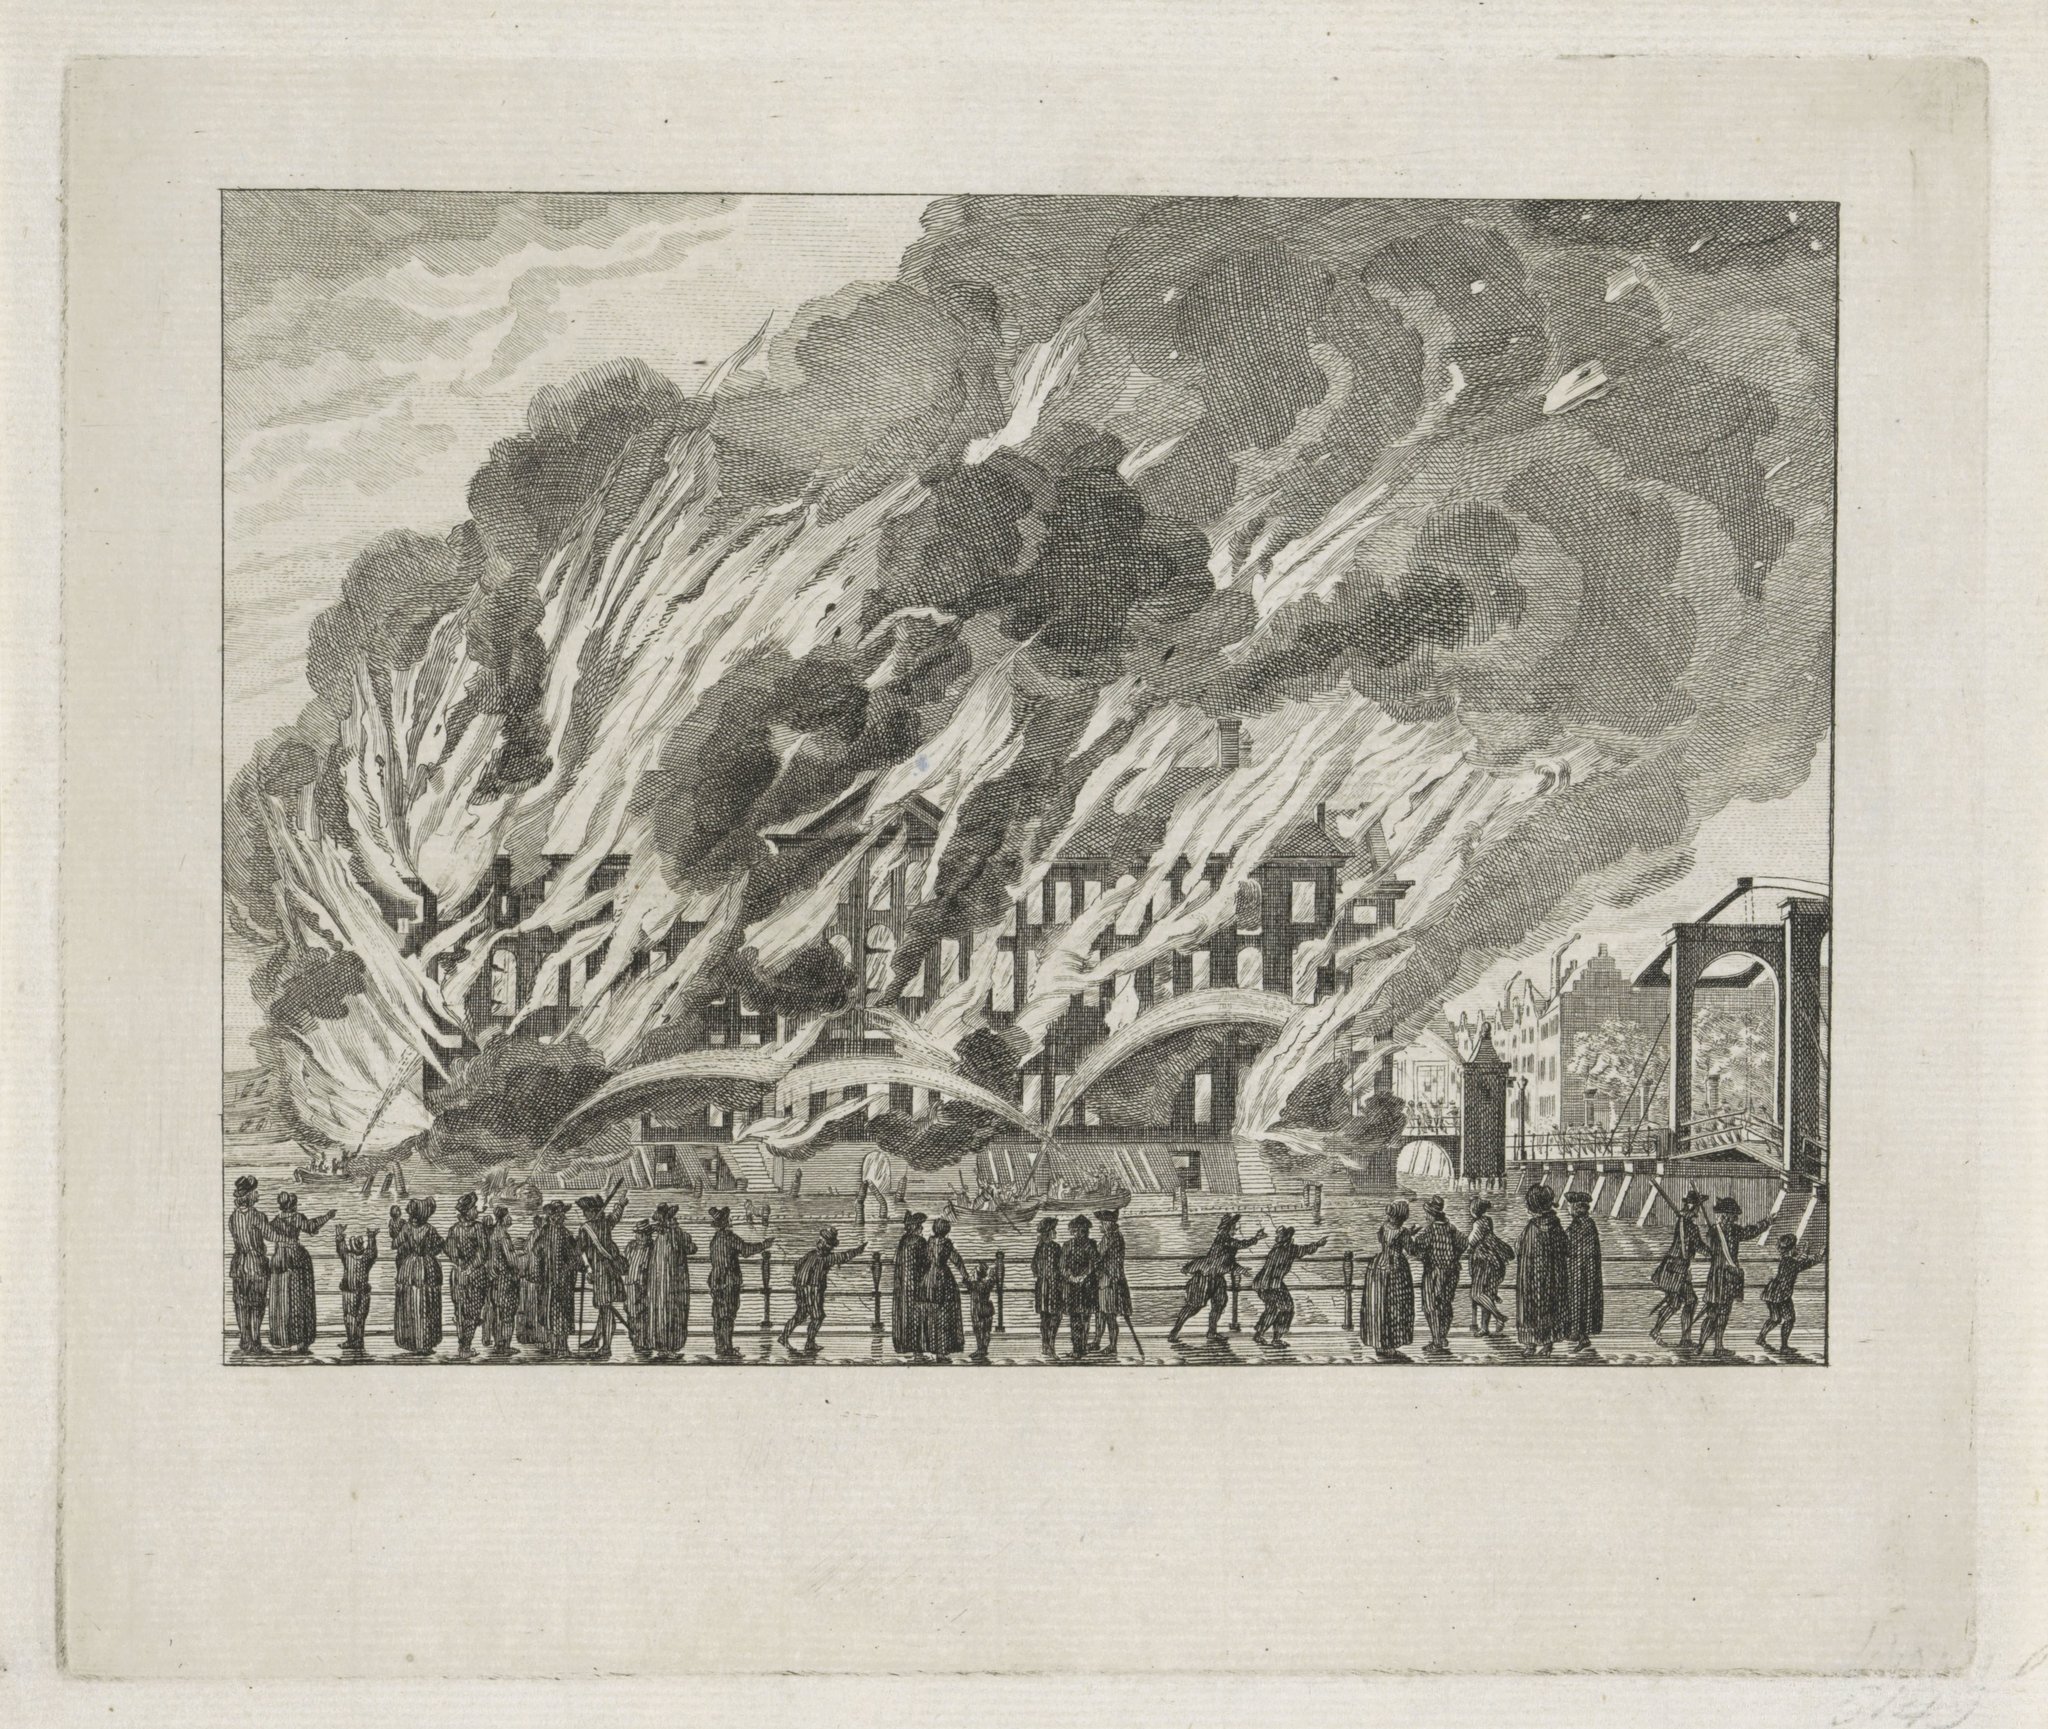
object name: print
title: Brand in 's Lands Zeemagazijn, 1791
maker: Anonymous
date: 1791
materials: paper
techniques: engraving, etching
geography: northern netherlands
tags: on fire, ablaze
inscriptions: collector's mark: Lugt 2228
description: Grote brand in 's Lands Zeemagazijn te Amsterdam op 6 juli 1791. Vanaf boten op het water wordt geprobeerd de brand te blussen.